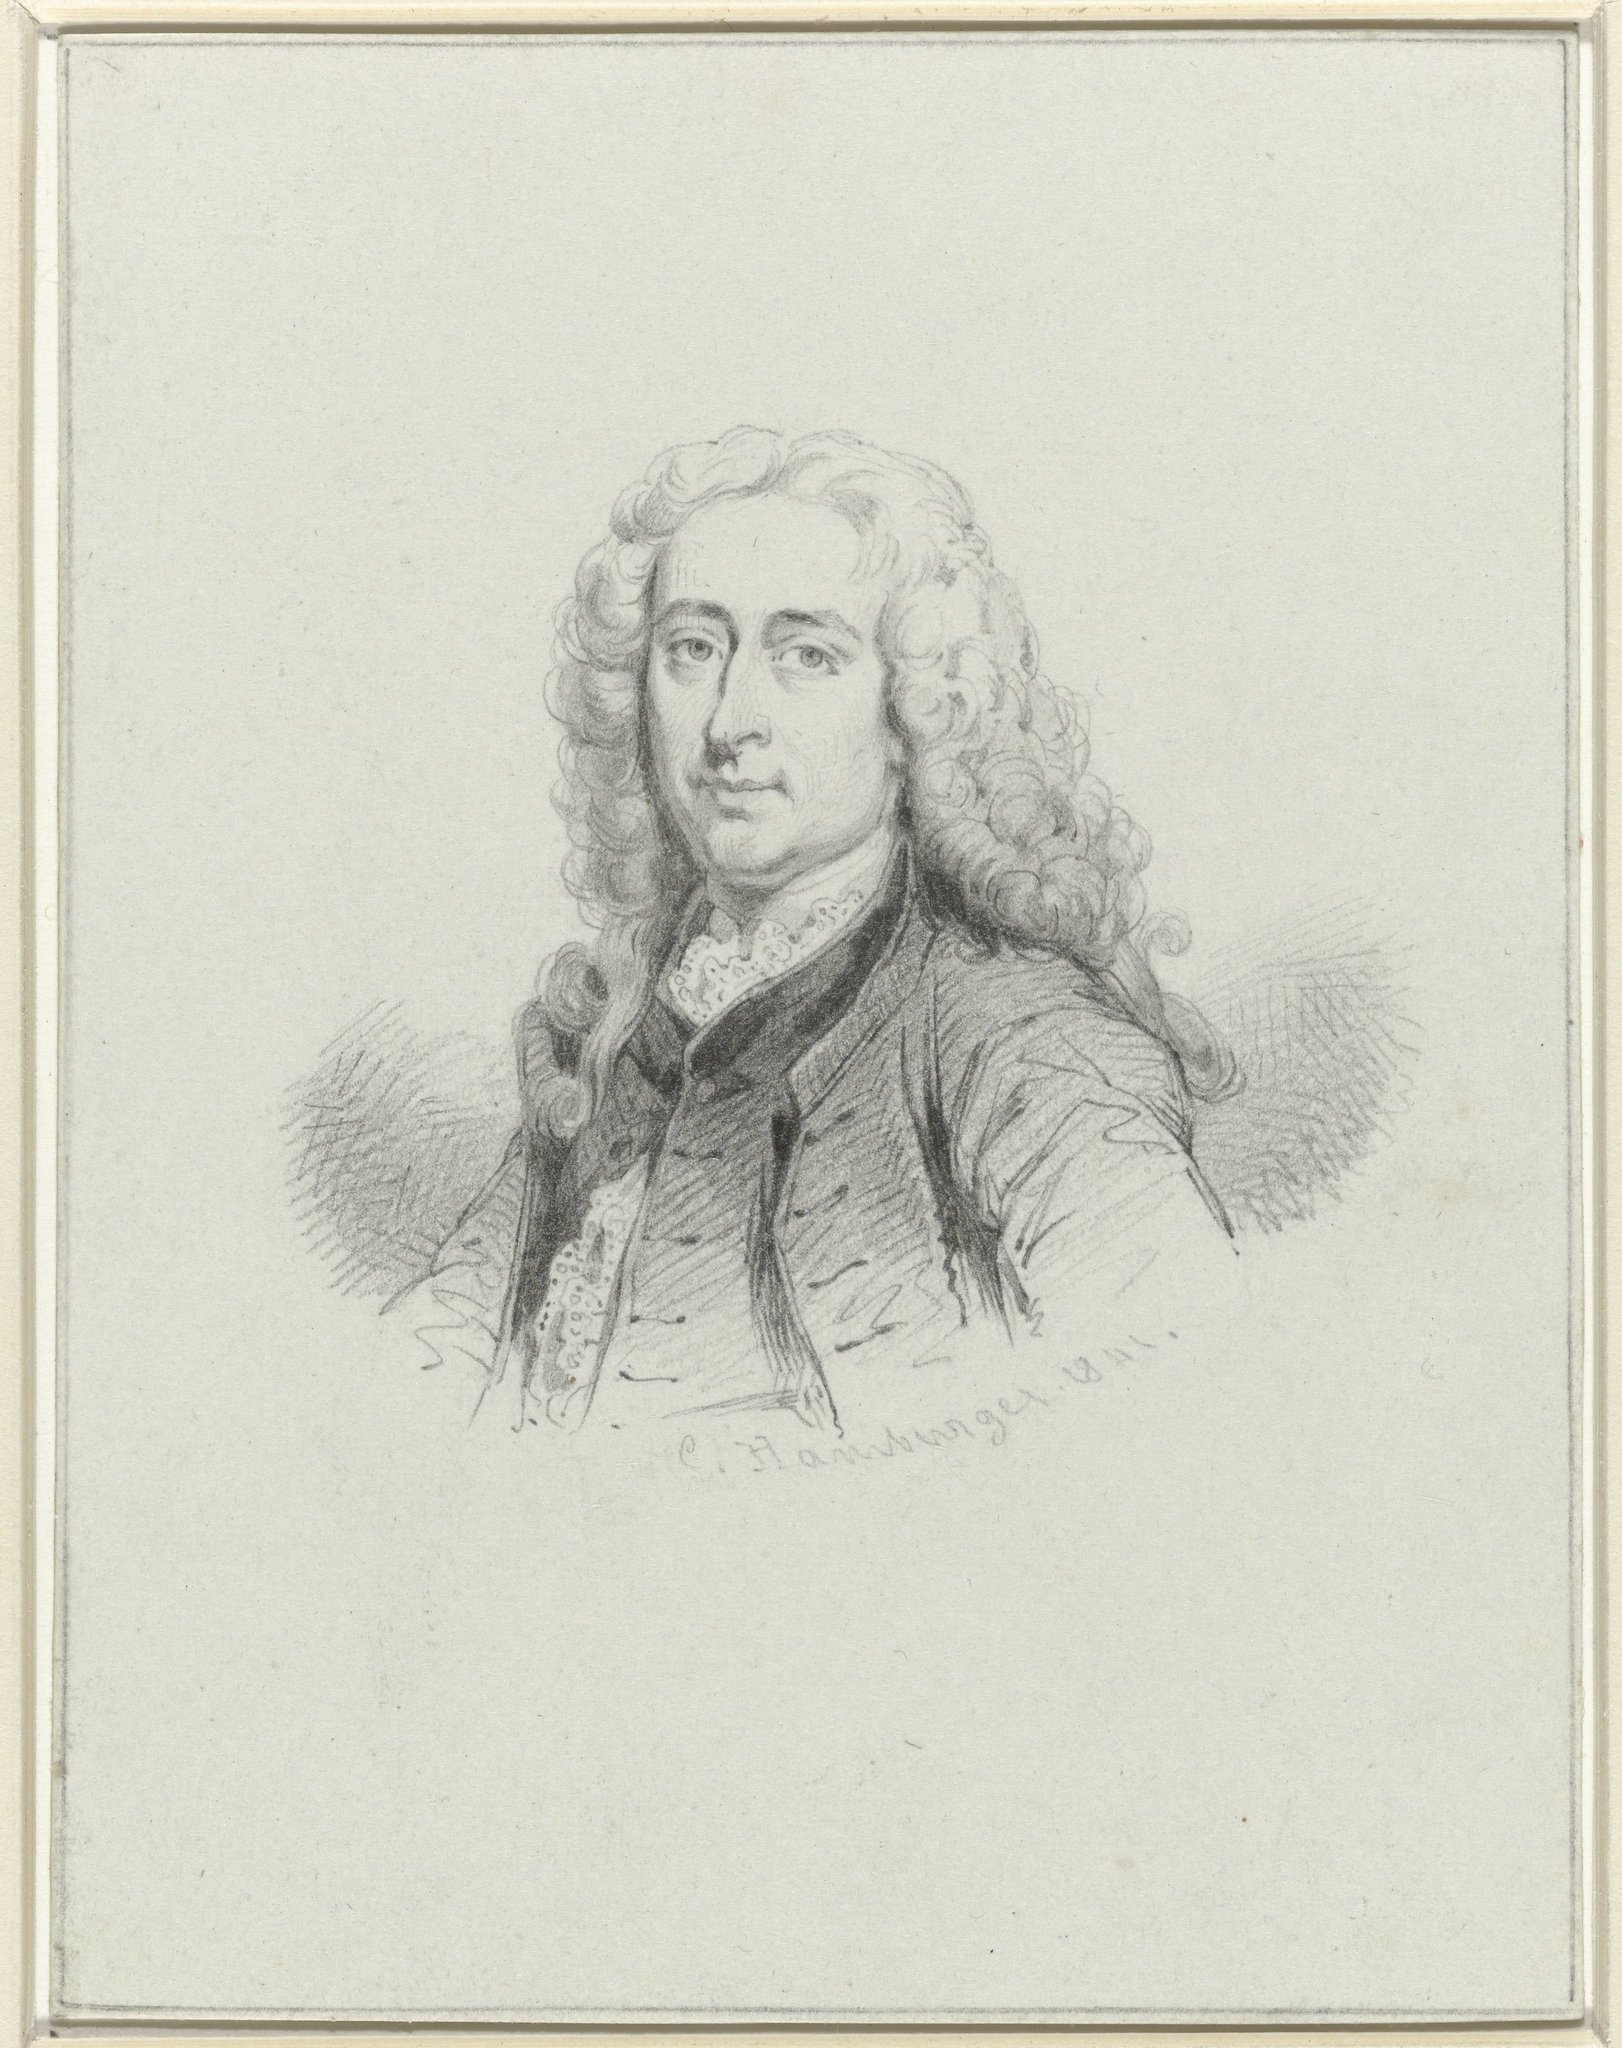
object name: drawing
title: Portret van Cornelis Troost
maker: coenraad hamburger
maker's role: draughtsman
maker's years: 1809-1891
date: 1841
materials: paper, pencil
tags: amsterdam, painter, print maker, draughtsman, cornelis troost, historical persons, portrait, self-portrait of painter, portrait, self-portrait of artist, portrait, self-portrait of graphic artist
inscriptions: date: ‘1841’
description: Portret van de schilder en graveur Cornelis Troost.